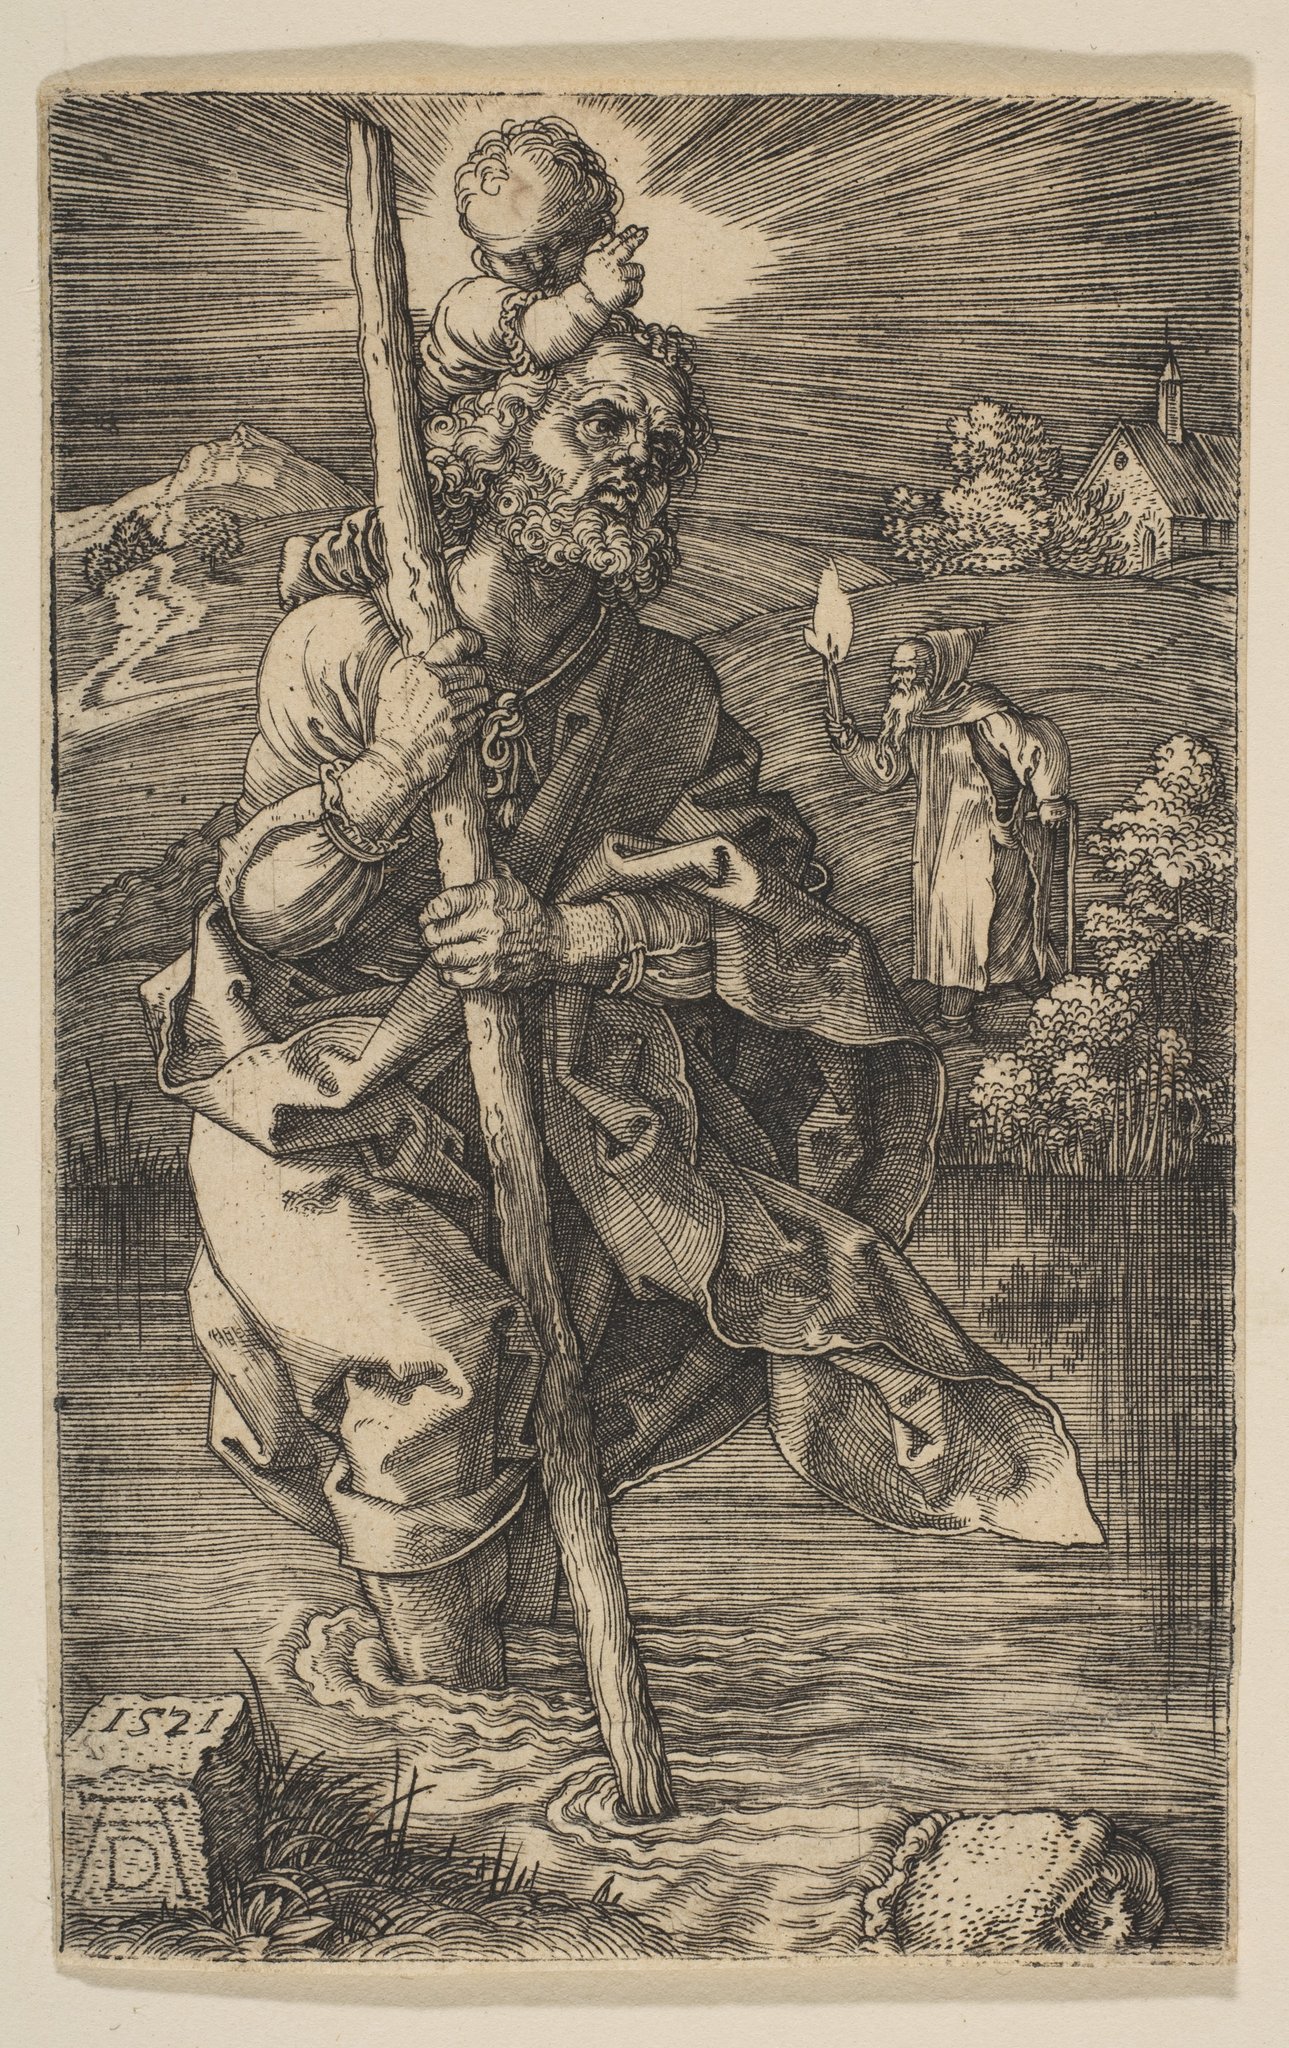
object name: print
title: Saint Christopher Facing Right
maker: albrecht dürer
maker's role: artist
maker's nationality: german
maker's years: 1471-1528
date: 1521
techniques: engraving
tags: saint christopher